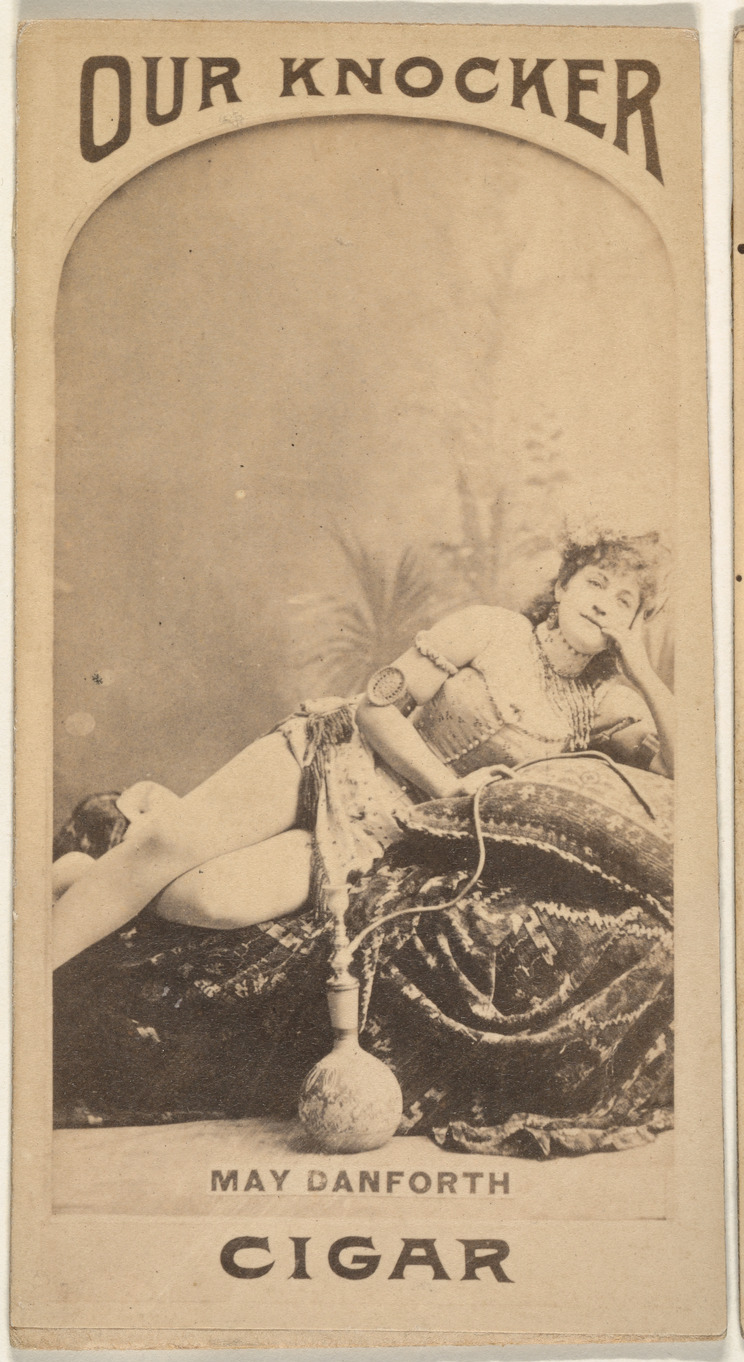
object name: photograph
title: May Danforth, from the Actresses series (N665) promoting Our Knocker Cigars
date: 1888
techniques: albumen silver print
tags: portraits,women,actresses